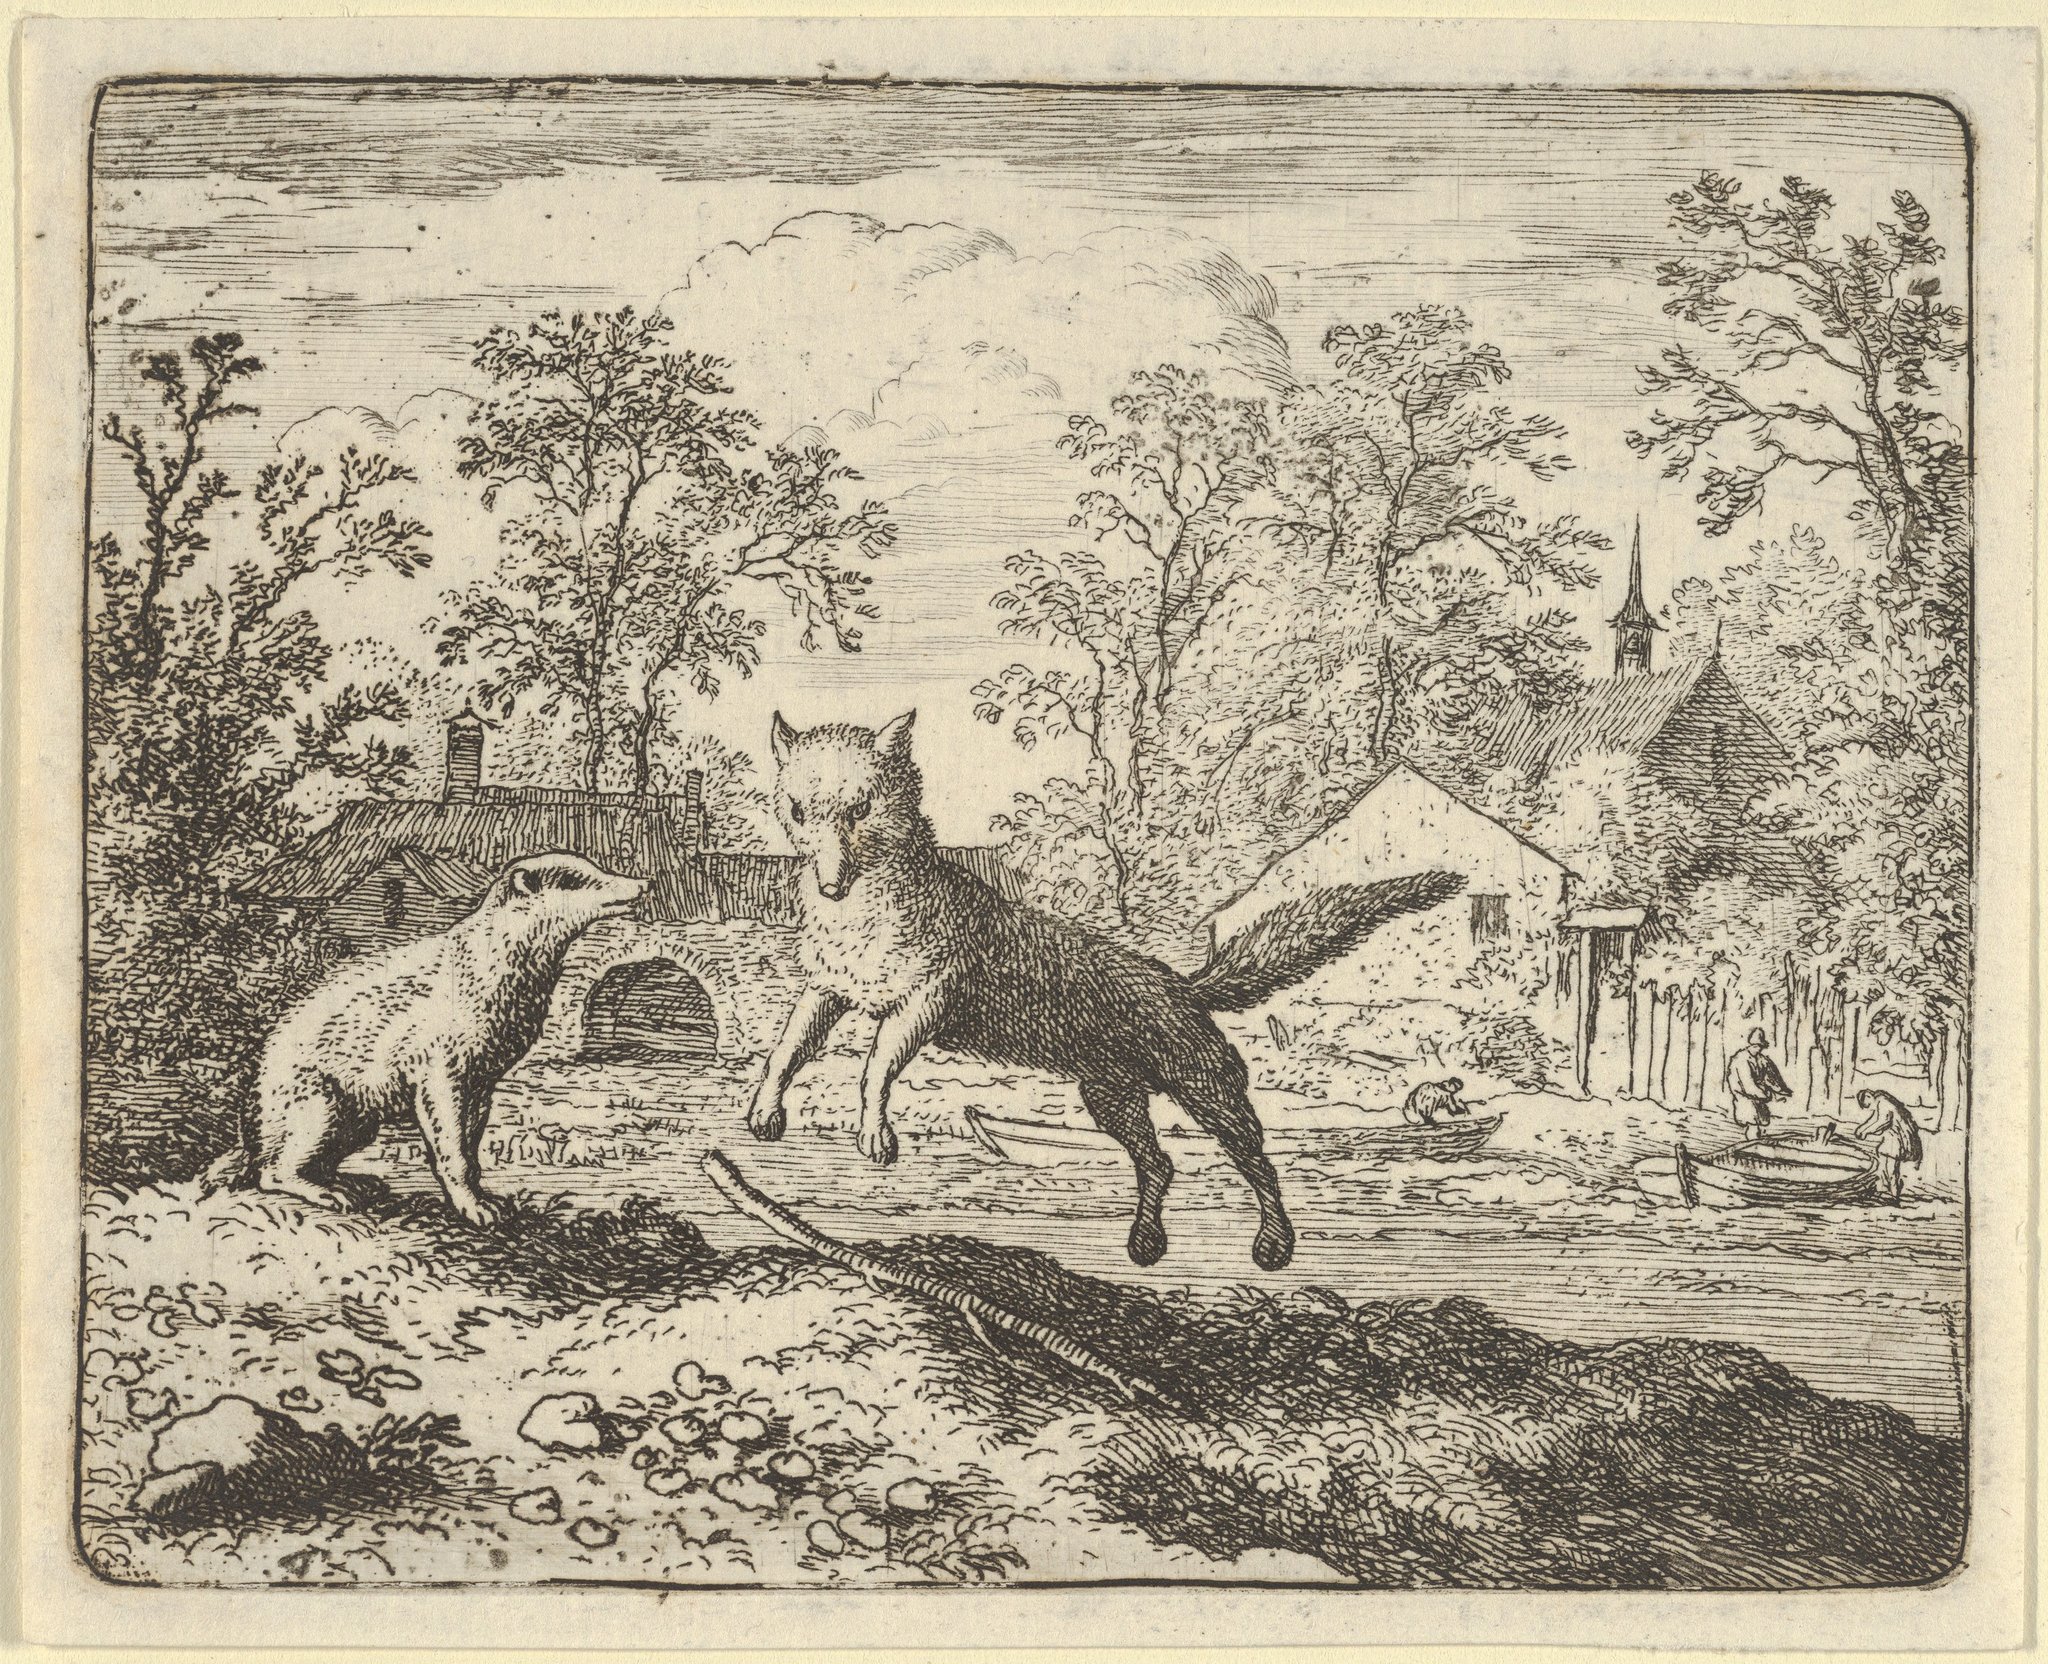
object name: print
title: The Badger Imposes as Punishment to Jump Three Times Over a Stick on the Ground from Hendrick van Alcmar's Renard The Fox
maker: allart van everdingen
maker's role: artist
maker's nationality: dutch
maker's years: 1621-1675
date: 1650-1675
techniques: engraving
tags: foxes